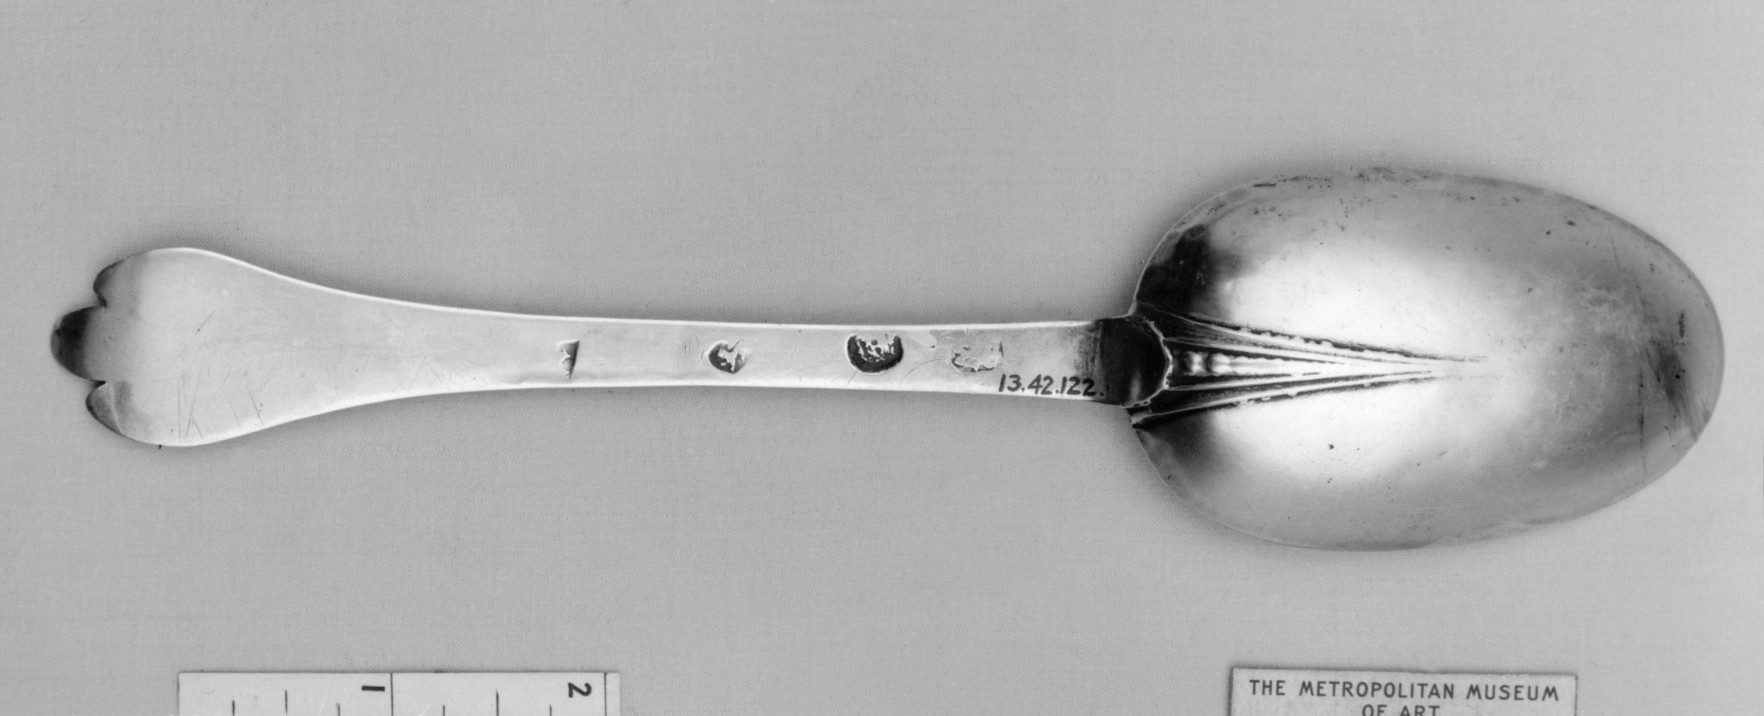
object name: spoon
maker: william scarlett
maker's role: maker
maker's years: 1689-1697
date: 1694-1695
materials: silver